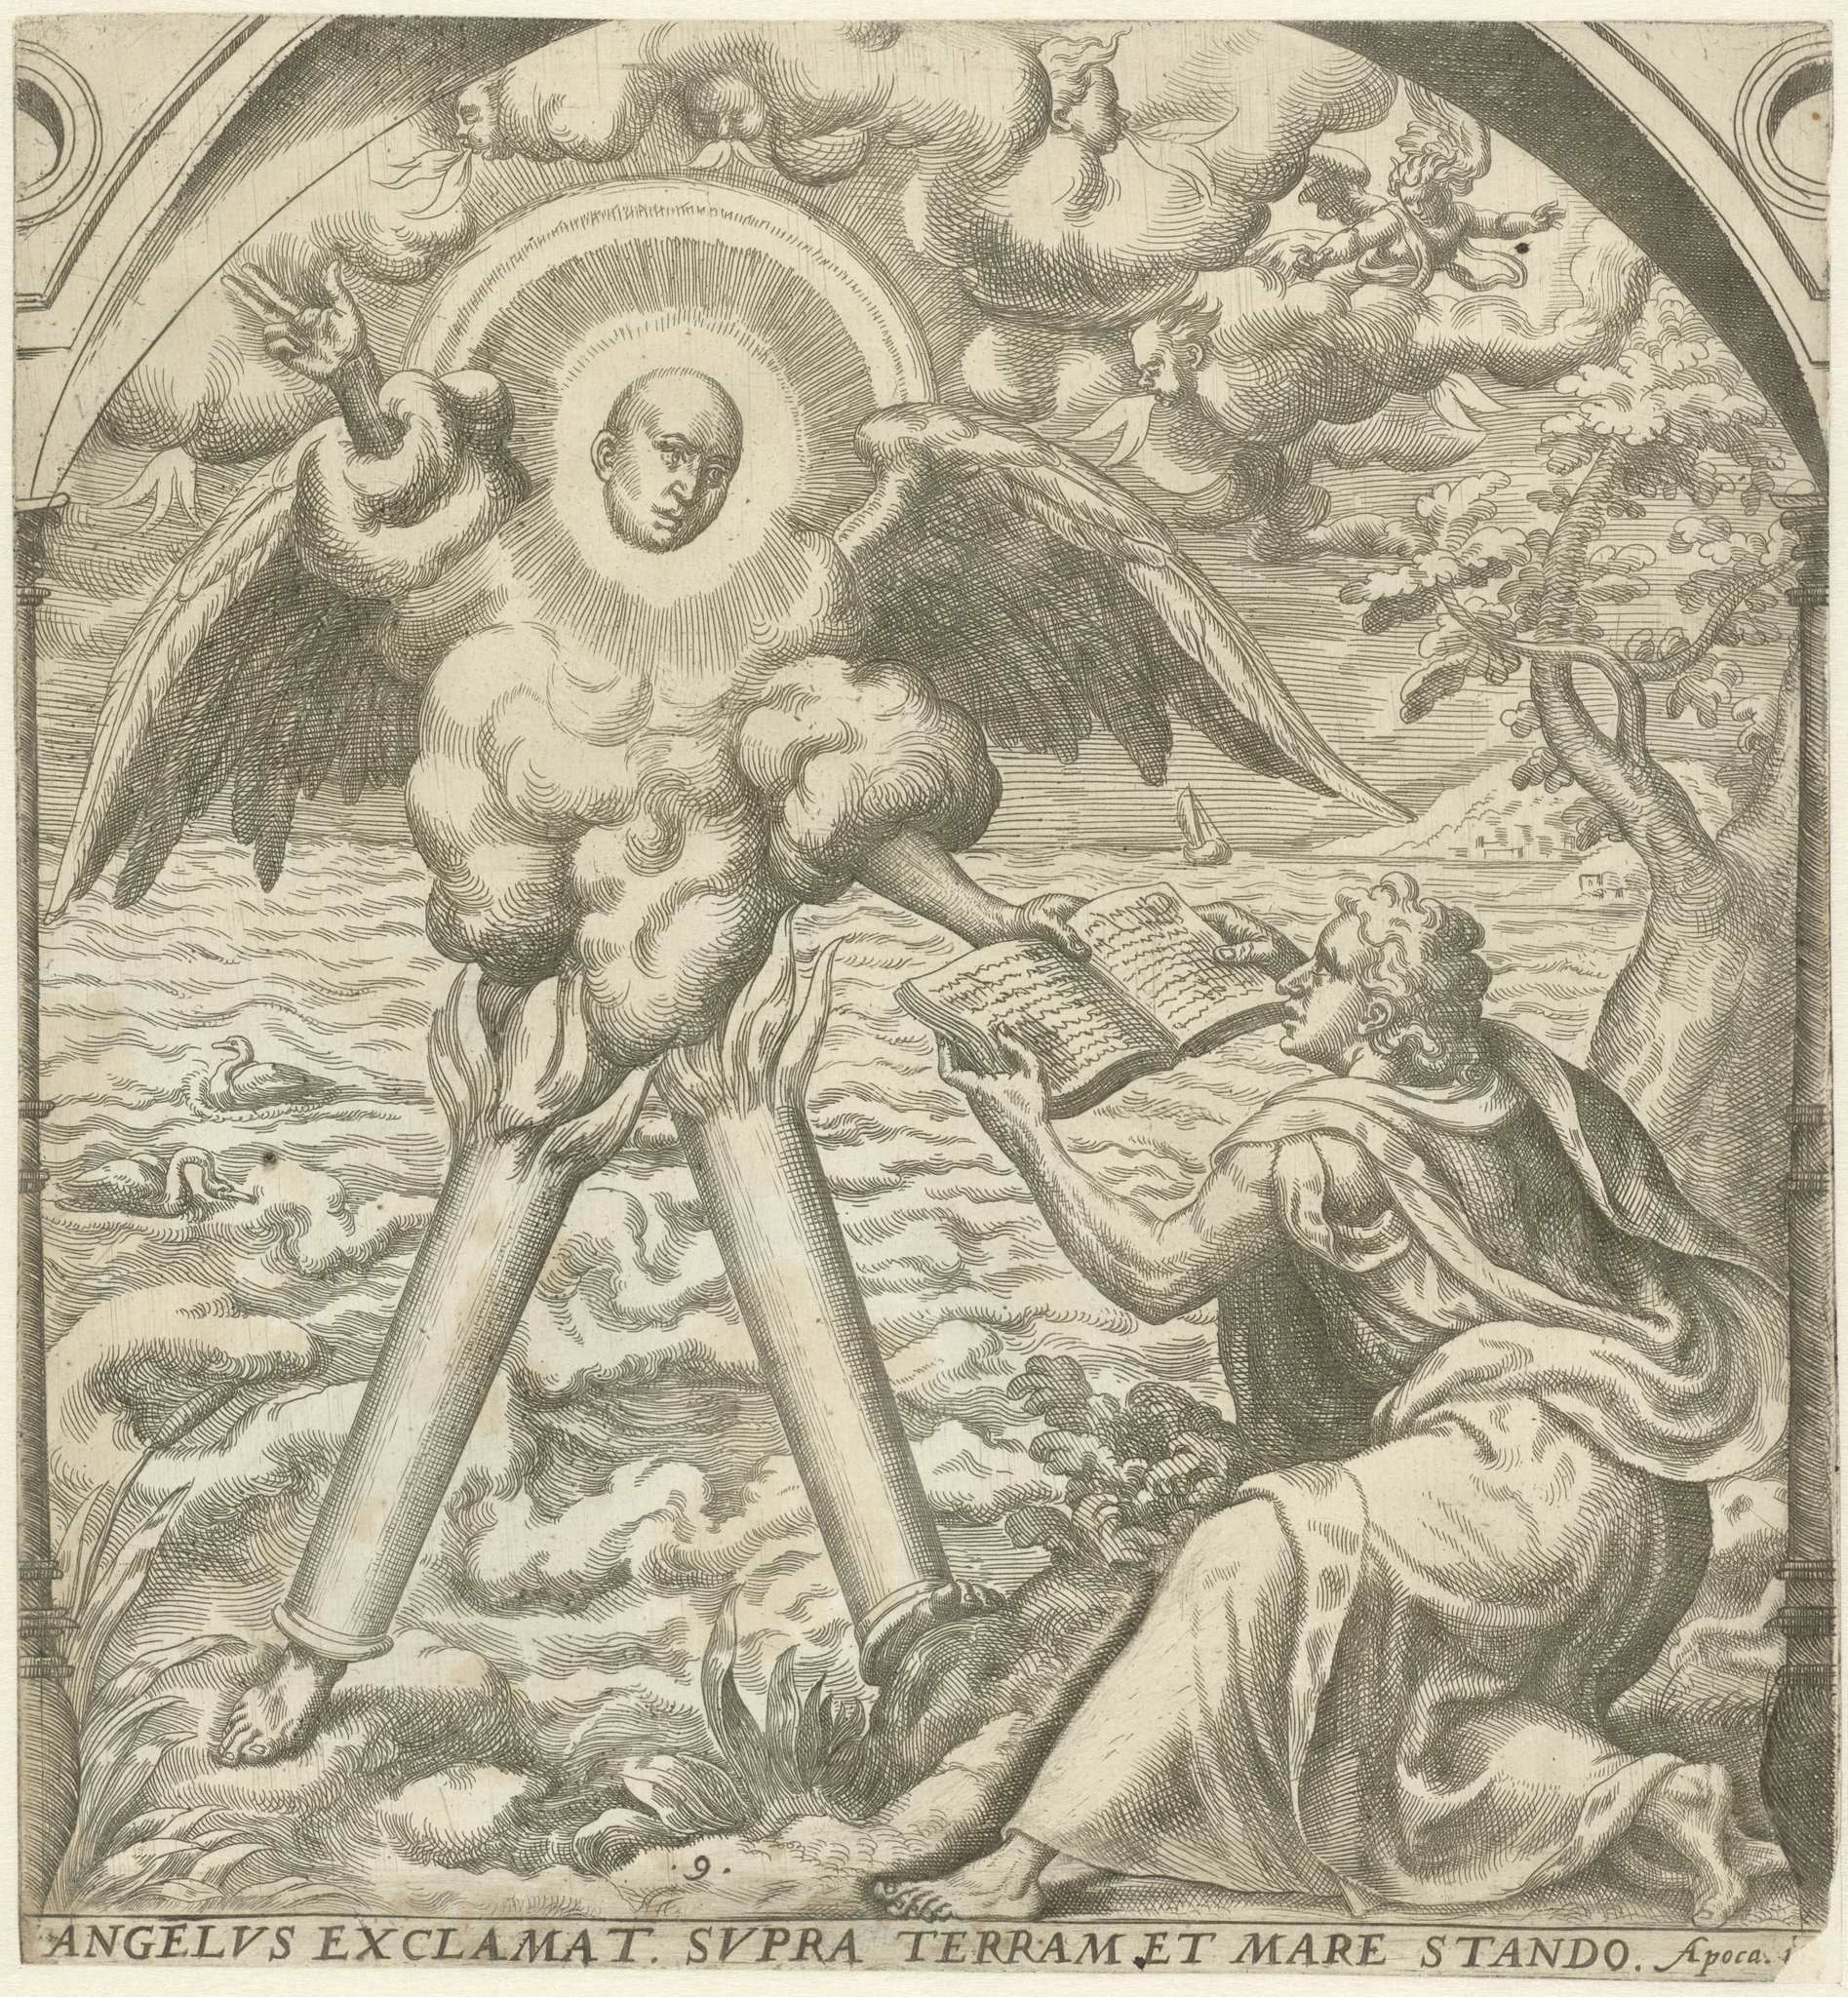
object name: print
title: Johannes ontvangt het heilig geschrift van een engel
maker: gerard van groeningen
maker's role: draughtsman, painter, print maker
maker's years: 1515-1599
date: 1563-1574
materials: paper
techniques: engraving, etching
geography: antwerp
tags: the mighty angel with the little open book in his hands: he is wrapped in a cloud; his legs are pillars of fire, which stand one on land and one in the sea ~ apocalypse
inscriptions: collector's mark: Lugt 2228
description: Een engel met een regenboog om zijn hoofd en met benen als zuilen van vuur daalt af uit de hemel. Zijn rechtervoet staat op het land en zijn linkervoet op de zee. De engel houdt de knielende apostel Johannes een open boek voor (Op. 10:1-11).